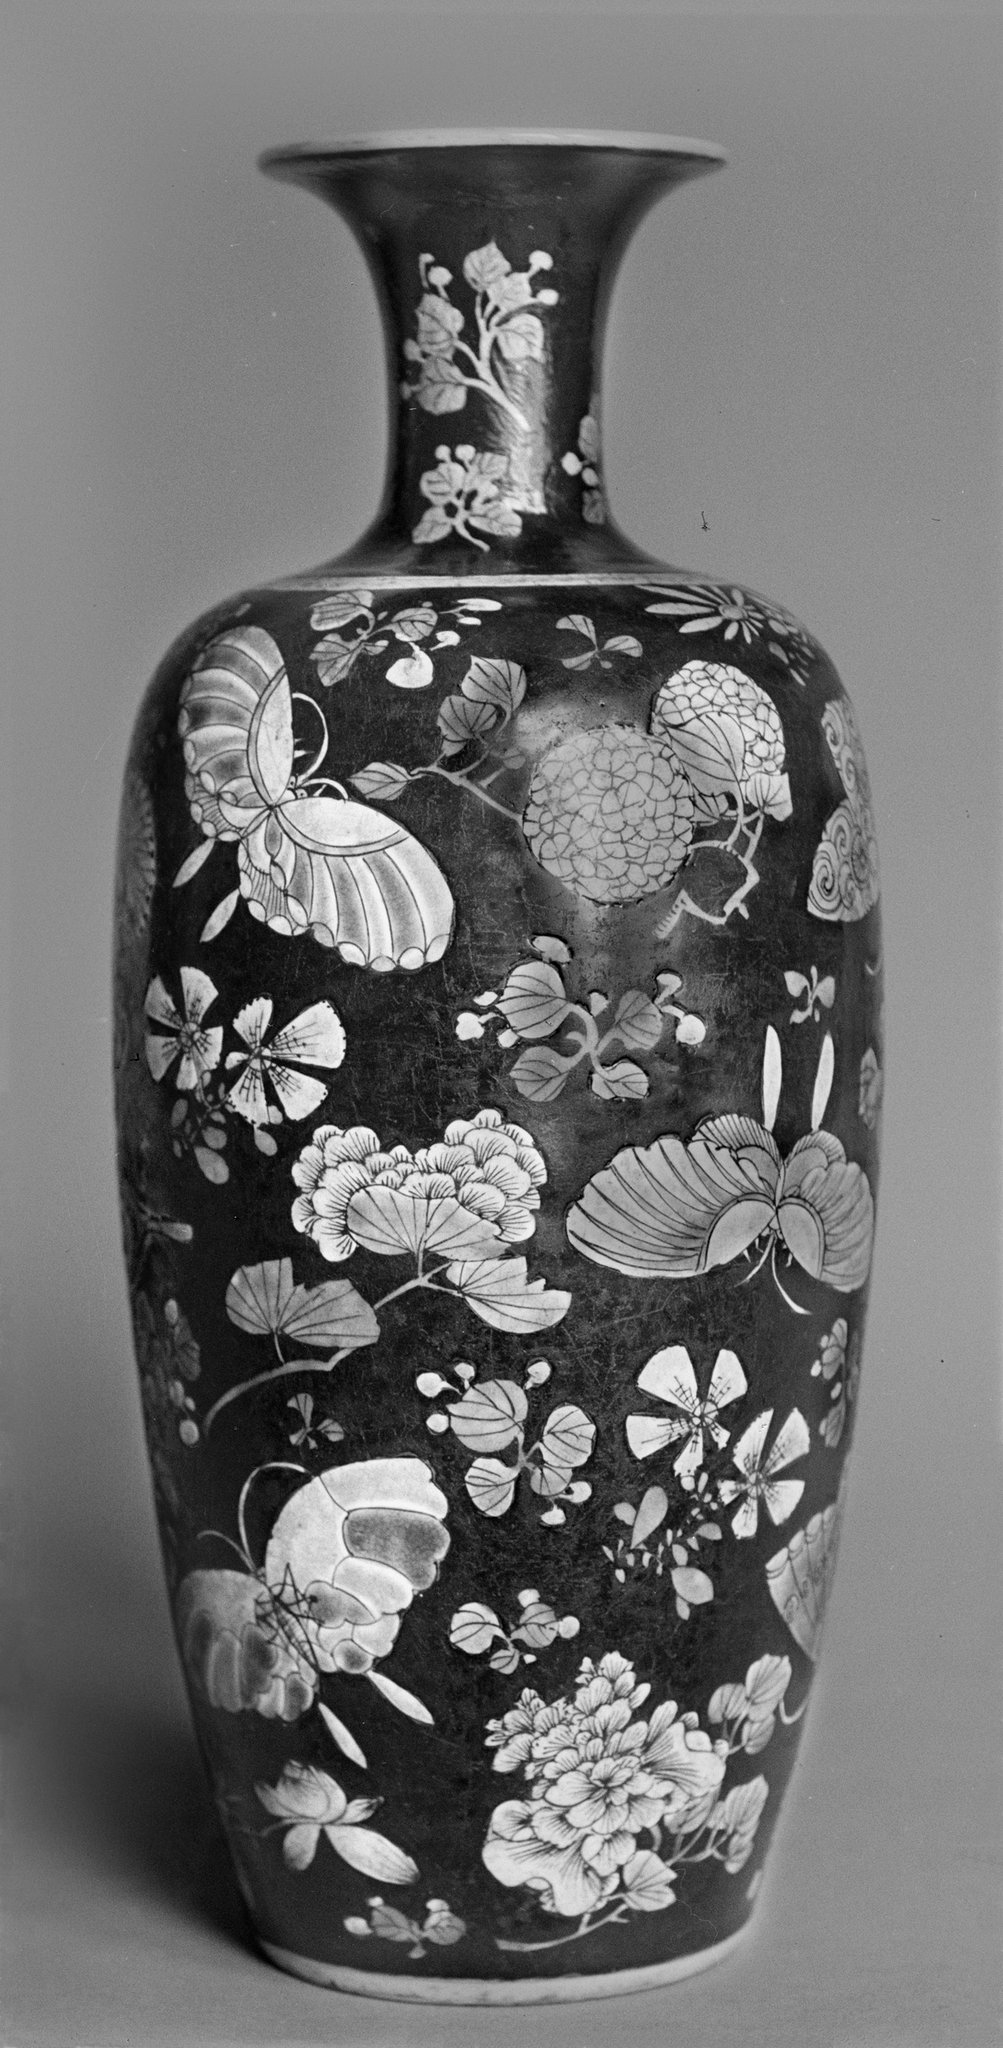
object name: vase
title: Vase with butterflies and flowers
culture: chinese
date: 1801-1900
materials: enamel, porcelain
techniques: polychrome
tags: butterflies,flowers